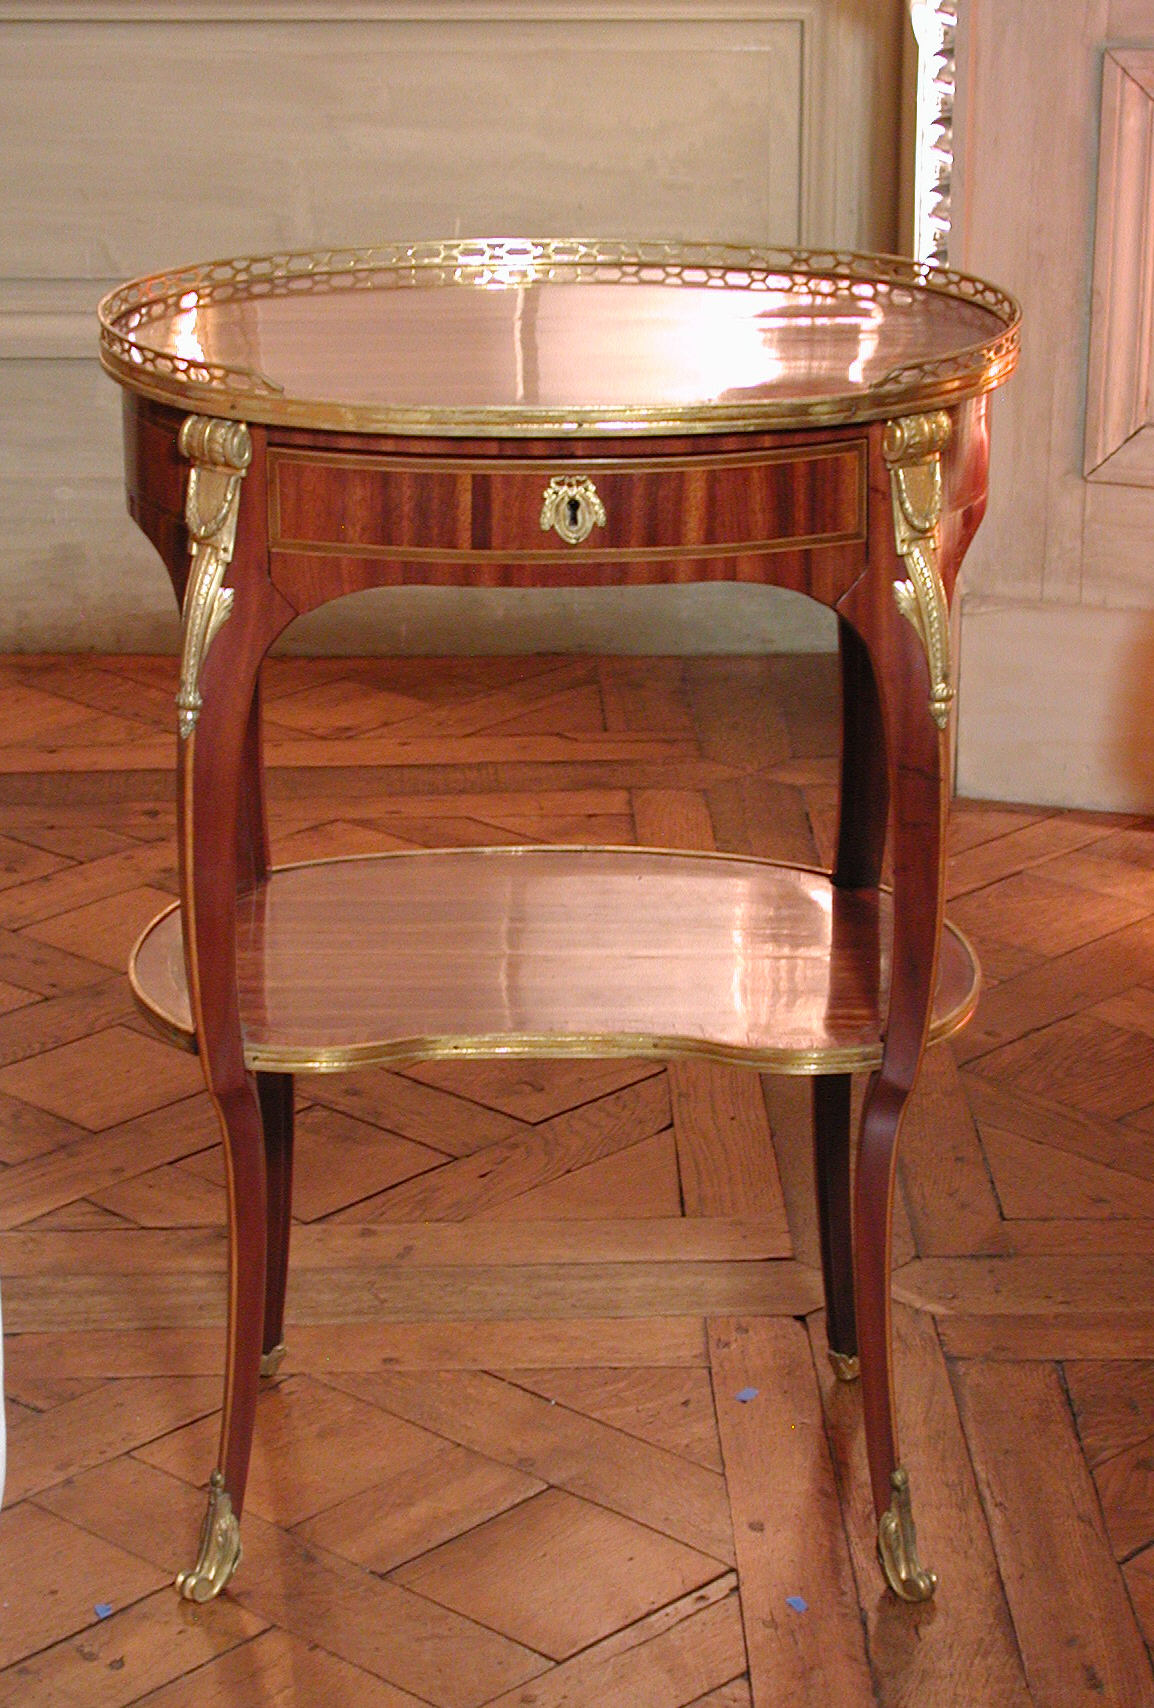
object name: writing table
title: Small oval writing table (one of a pair)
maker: roger vandercruse, called lacroix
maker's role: maker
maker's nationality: french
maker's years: 1727-1799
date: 1775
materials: gilt bronze, leather, wood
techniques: veneering